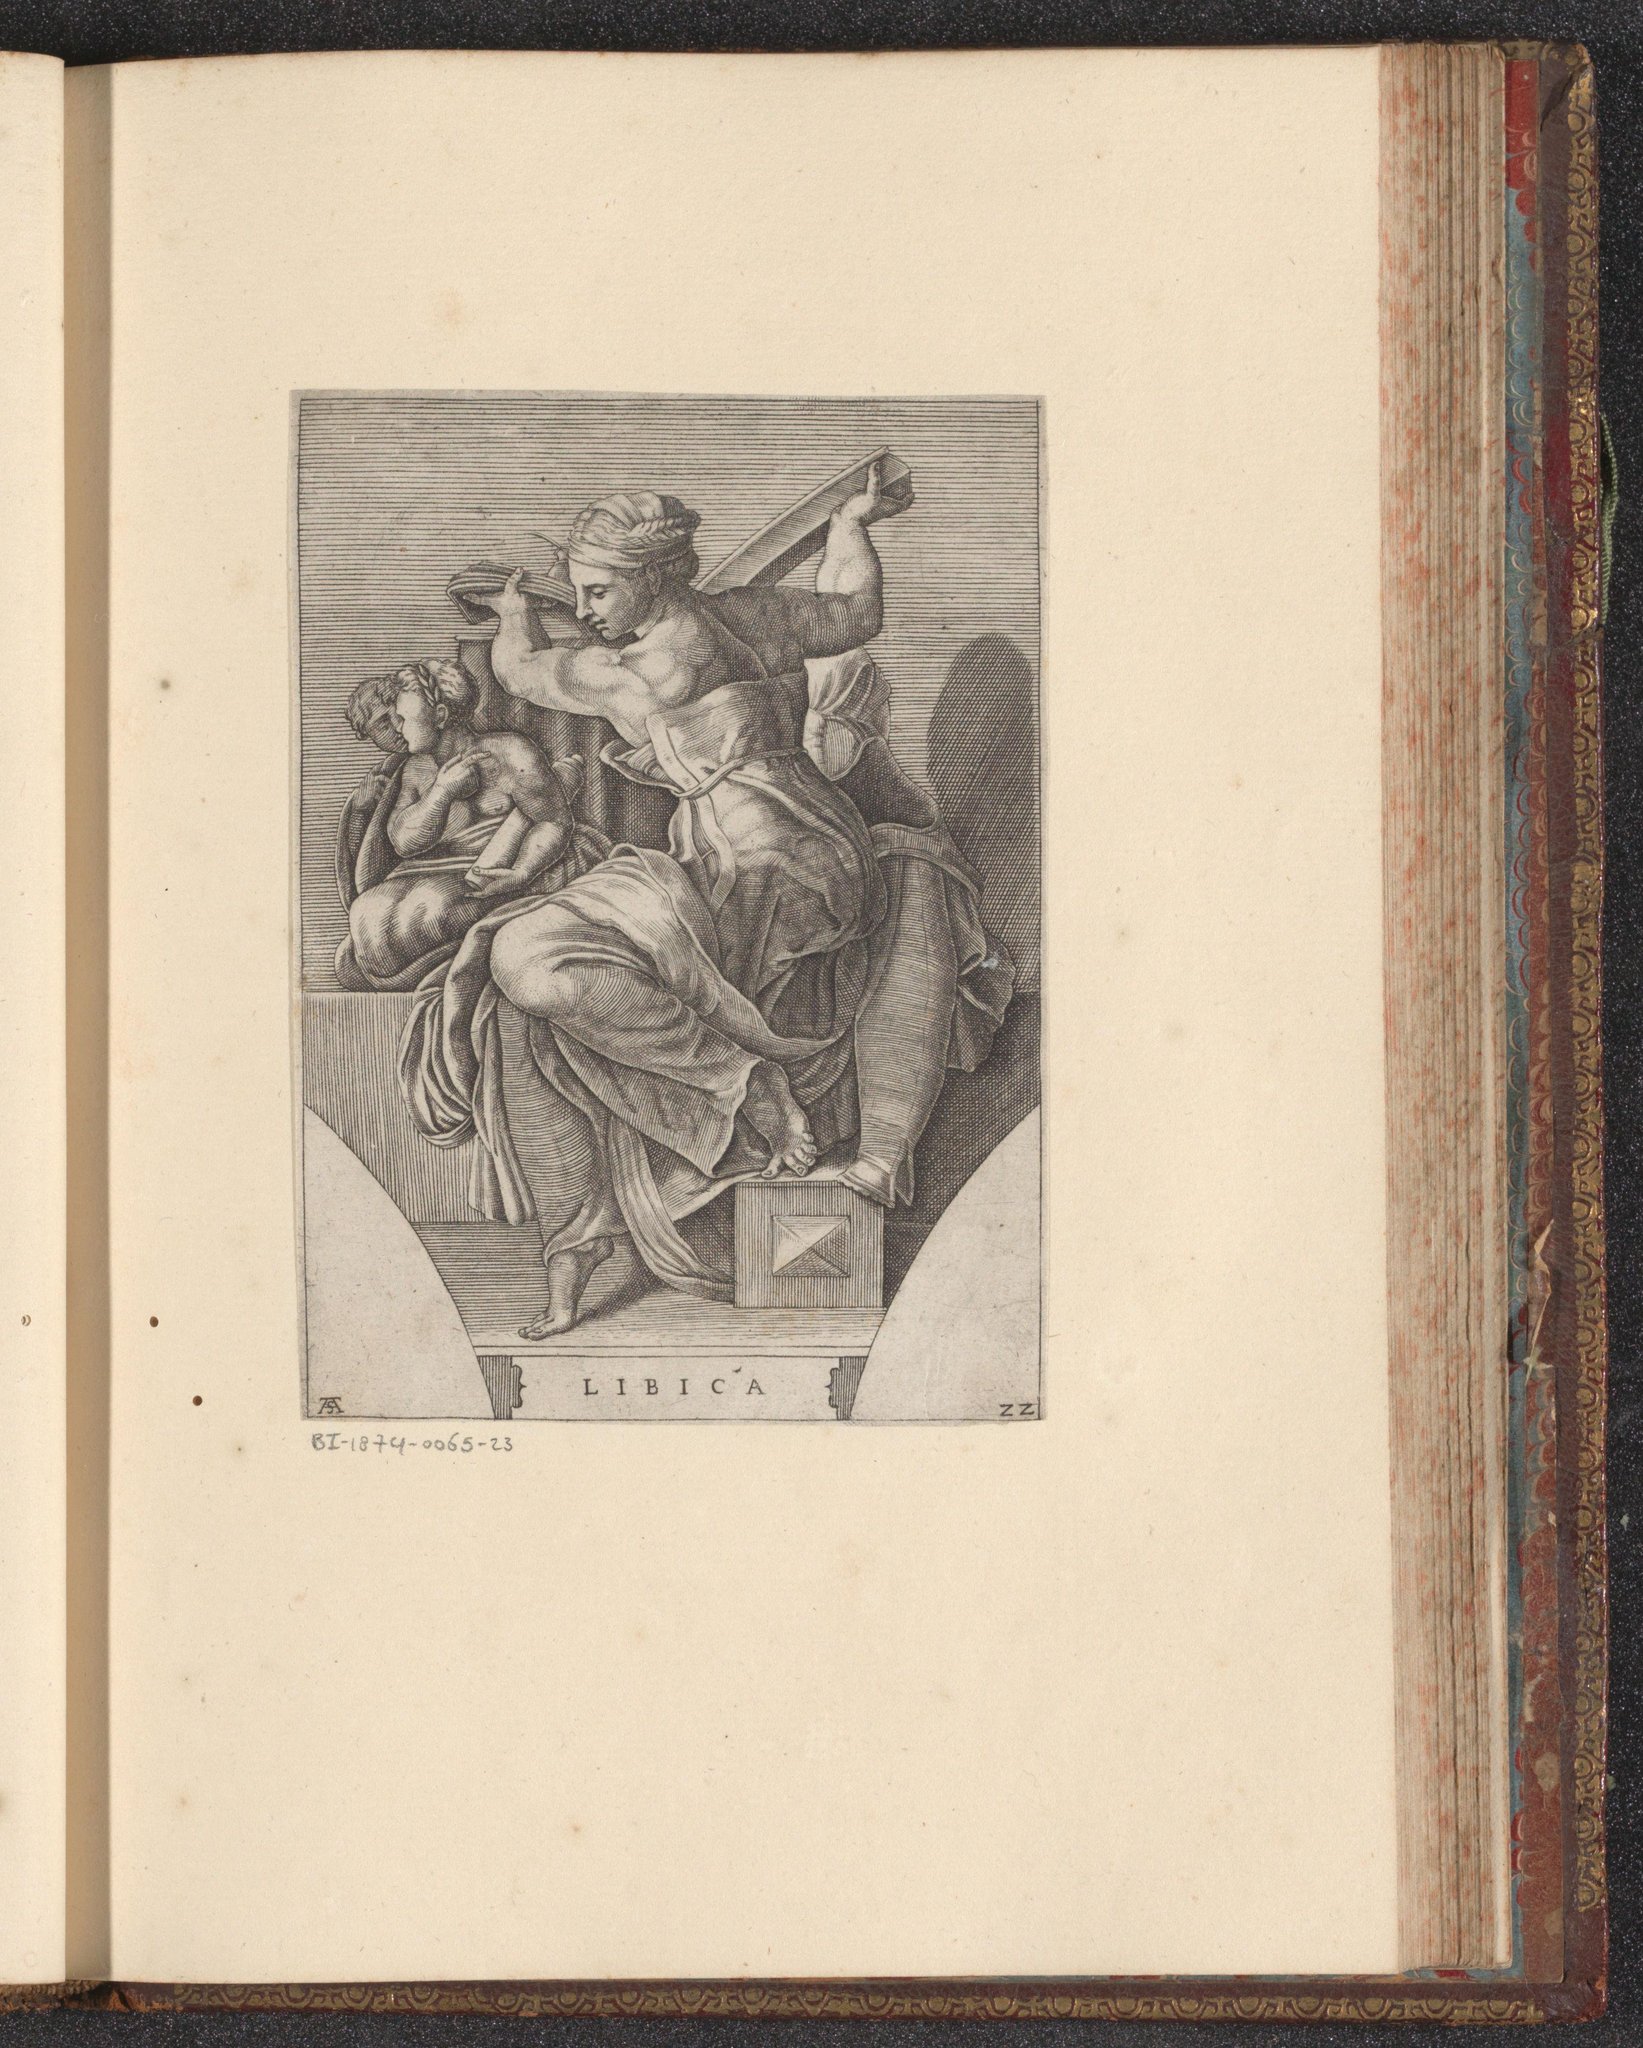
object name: album leaf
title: Schilderingen in de Sixtijnse kapel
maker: adamo scultori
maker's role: painter, print maker, sculptor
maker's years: 1530-1585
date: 1585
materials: paper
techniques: engraving, intaglio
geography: vatican city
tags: sibyls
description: De Libische Sibille, zittend en naar links gedraaid. Achter haar een groot boek dat zij met beide handen omhoog tilt. Links twee kinderen met een boekrol. Eén van de Sibillen van Michelangelo's plafondschildering. Titel in ondermarge en genummerd rechtsonder: 22. De prent maakt deel uit van een album.